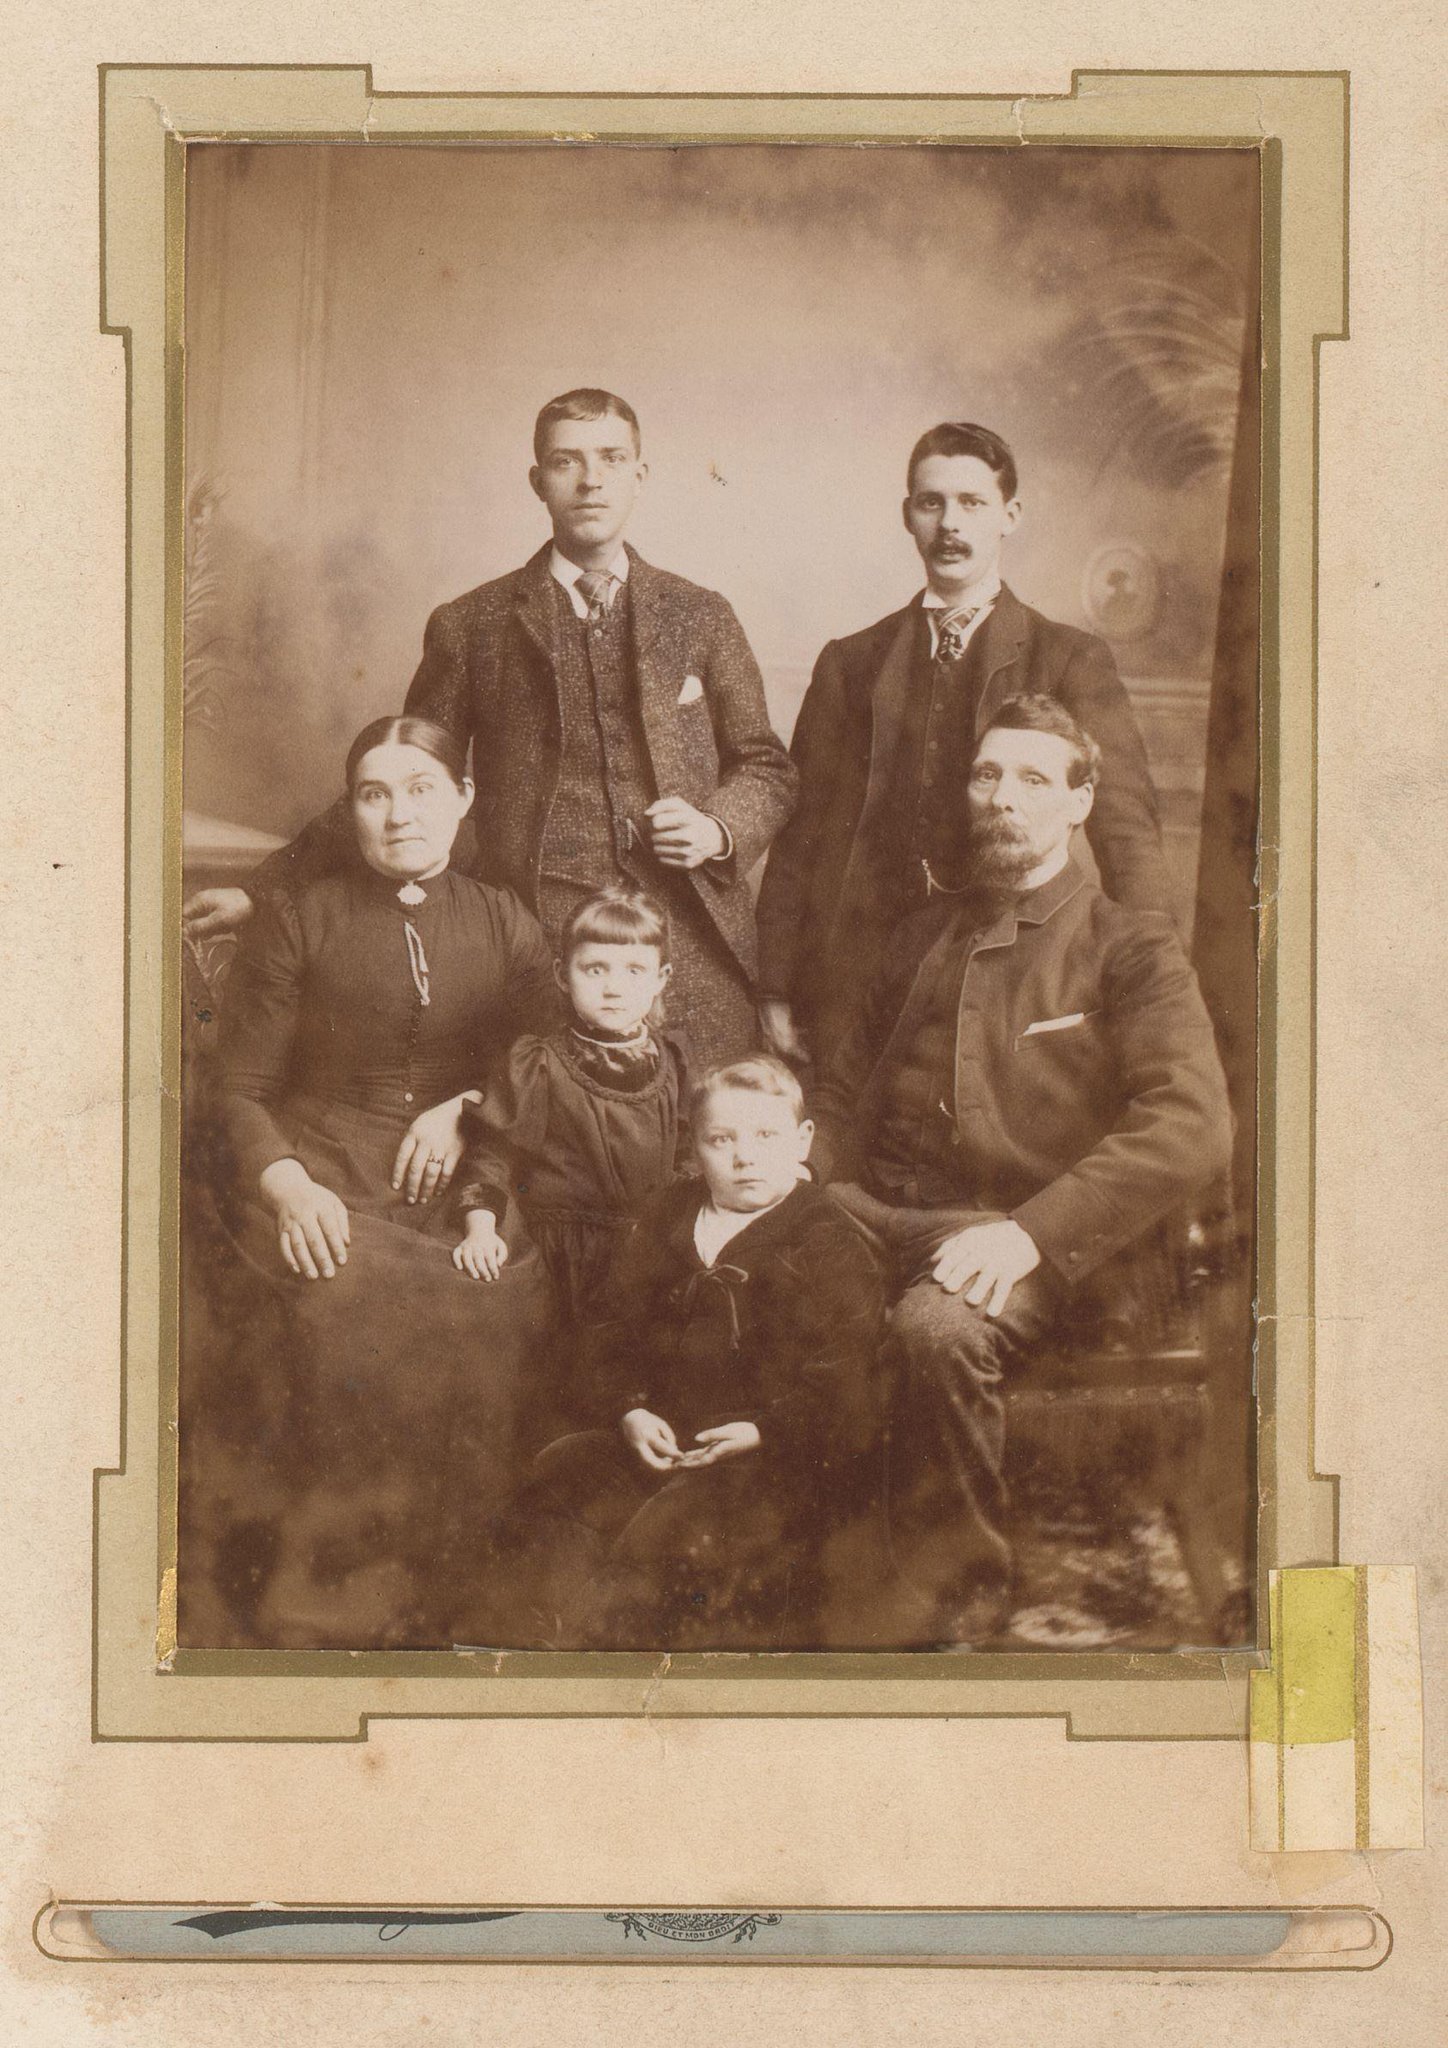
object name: cabinet photograph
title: Familieportret van een vrouw, mannen en kinderen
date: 1860-1900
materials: cardboard, photographic support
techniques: albumen print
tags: adult woman, parents with their children, adult man, child, historical persons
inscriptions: inscription: ‘(...)/ A. & G. Taylor/ 12, Norfolk St/ Sunderland/ 68, Newgate St. Bishop Auckland/ 106, High St. Stockton,/ 4 St Nicholas Buildings Newcastle on Tyne,/ and 18, Bank St. Carlisle/ (...)’